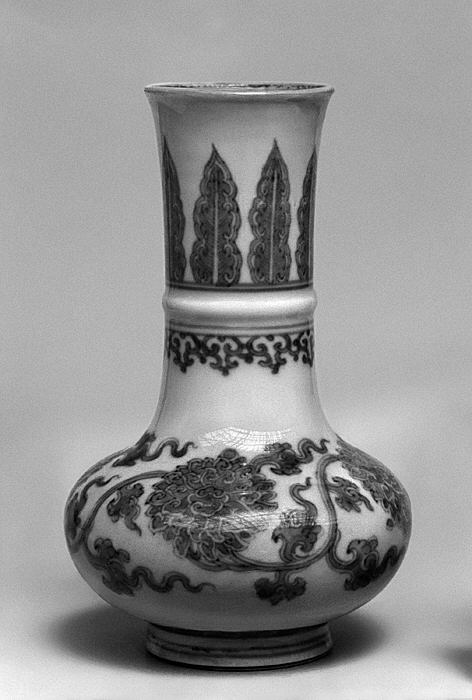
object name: bottle vase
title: Bottle vase with floral scrolls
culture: chinese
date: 1667-1733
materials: cobalt, porcelain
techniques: underglaze